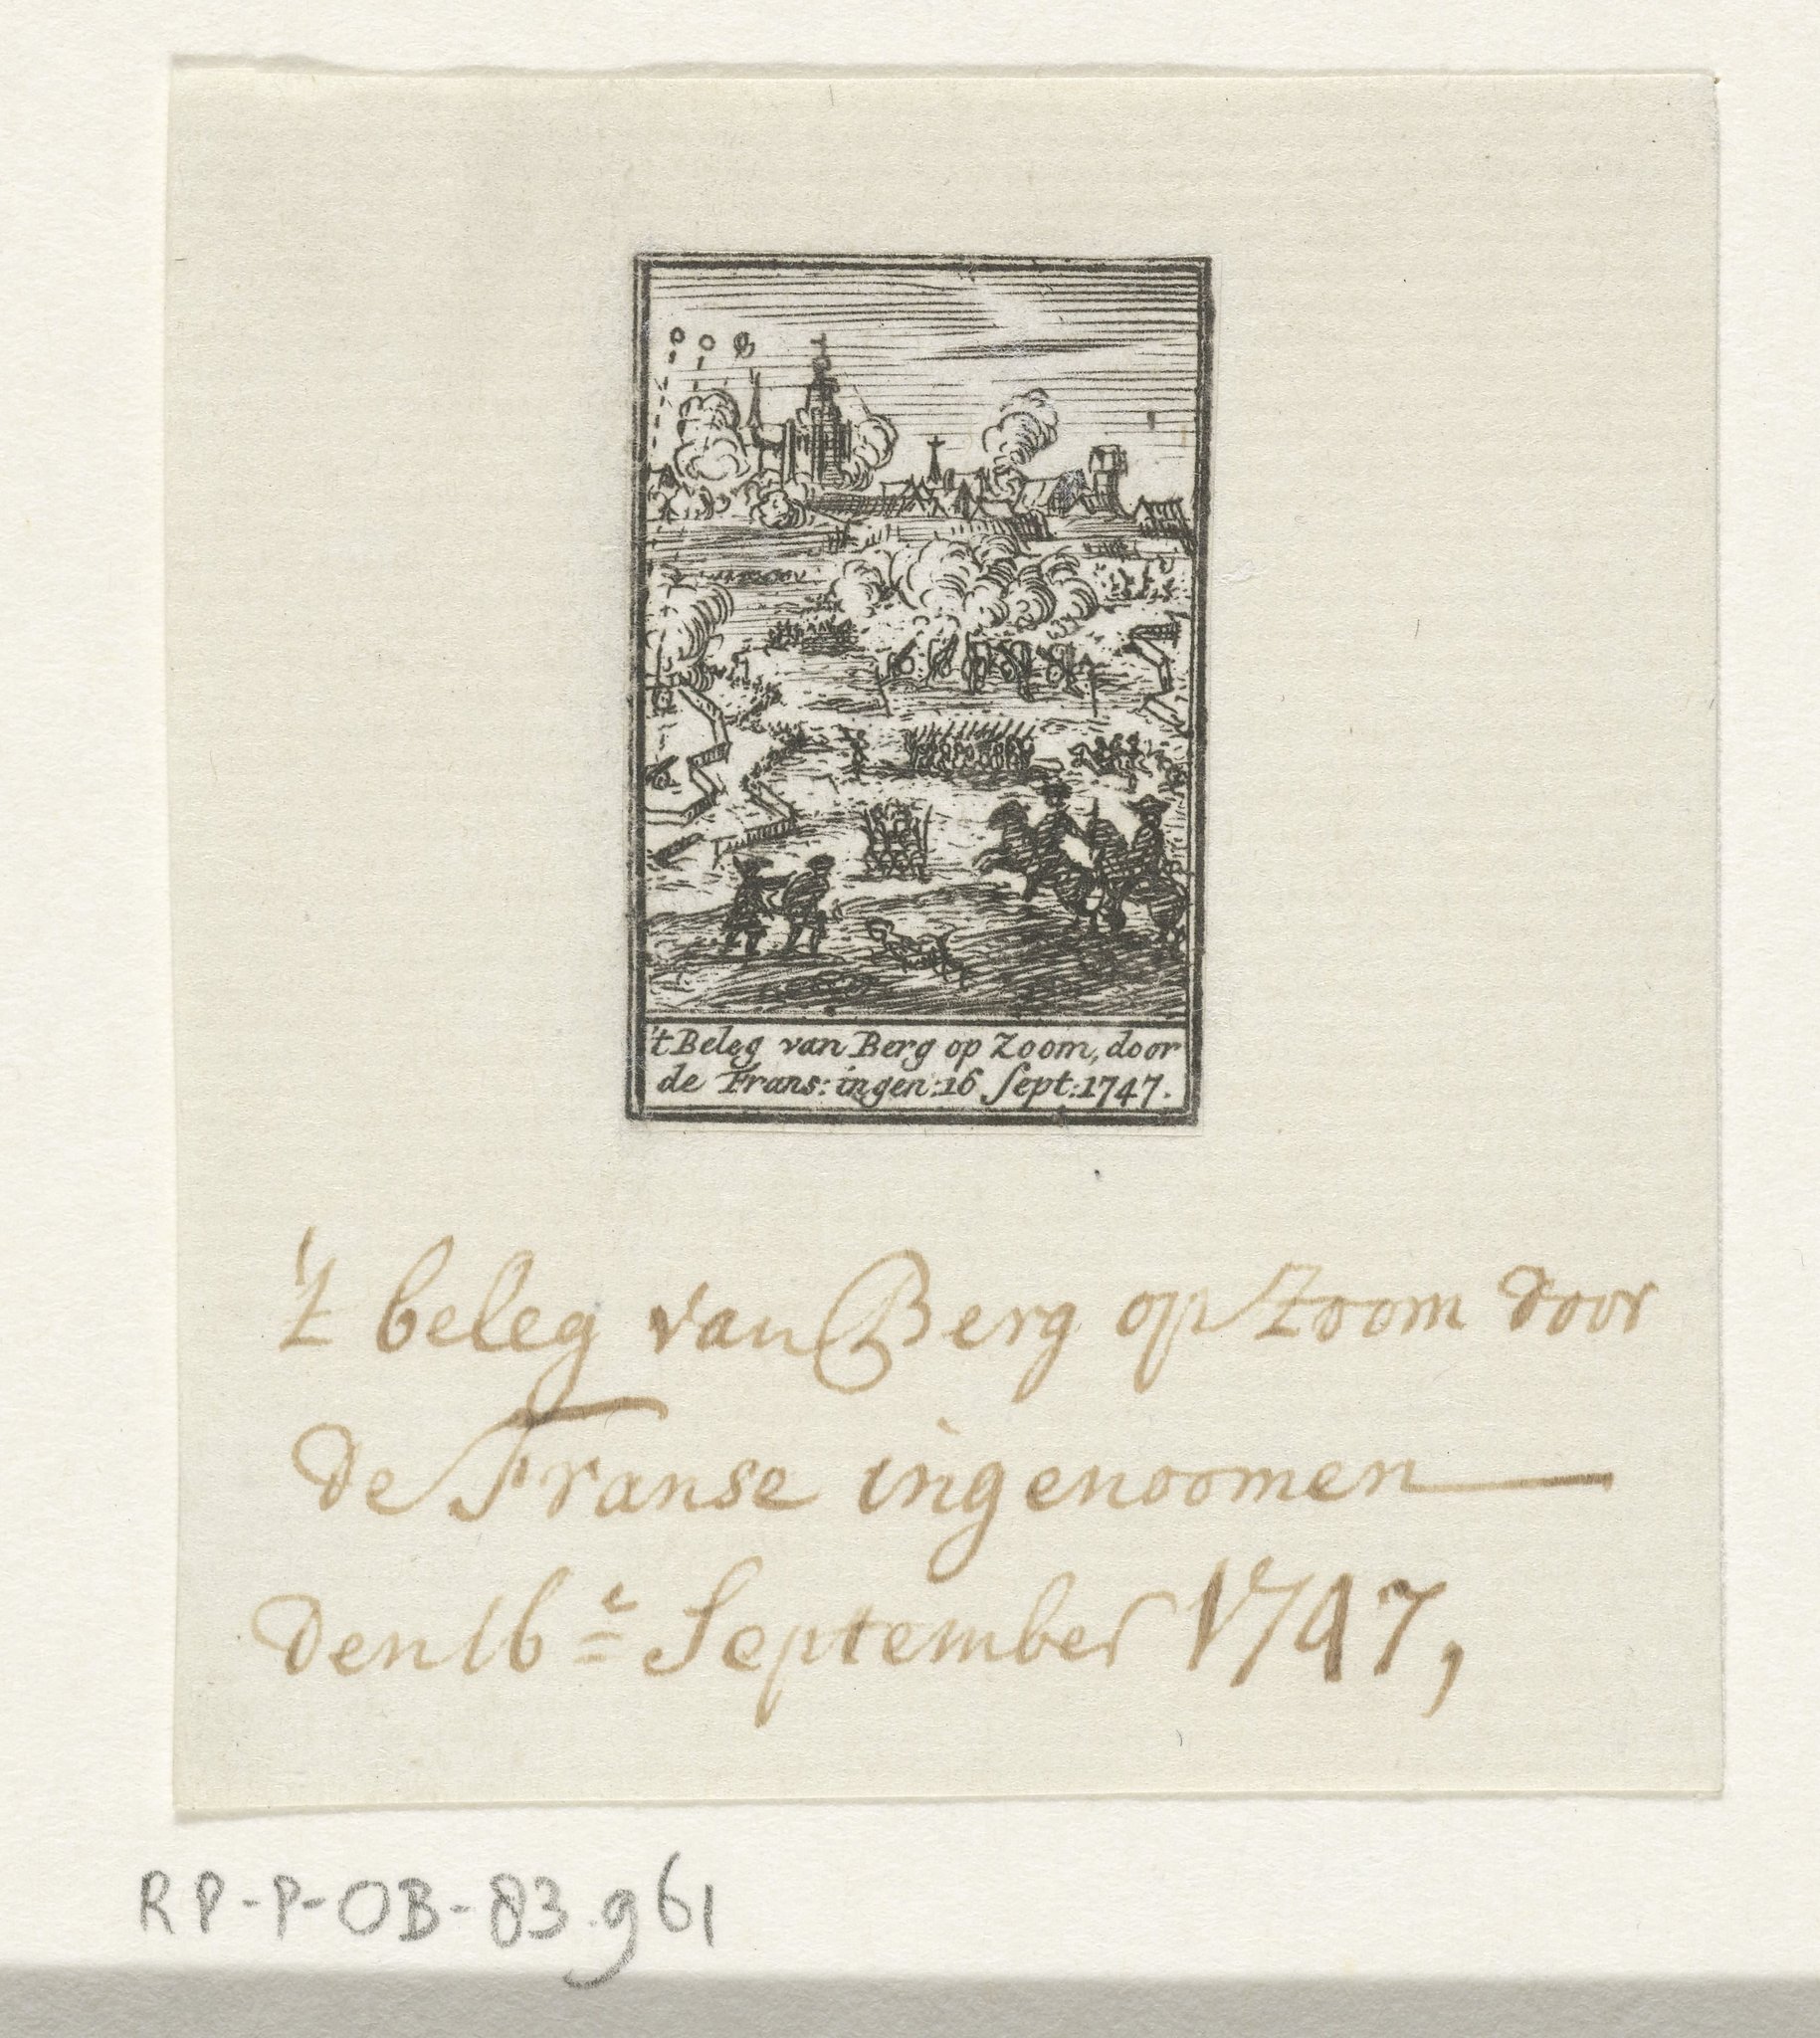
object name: print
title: Beleg van Bergen op Zoom, 1747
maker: Anonymous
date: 1747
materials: paper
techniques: etching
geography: northern netherlands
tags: siege, position war, bergen op zoom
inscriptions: inscription: ‘'t beleg van Berg op Zoom door de Franse ingenoomen den 16e September 1747,’, collector's mark: Lugt 2233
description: Zeer kleine voorstelling van het beleg van Bergen op Zoom door de Fransen in juli-september 1747.